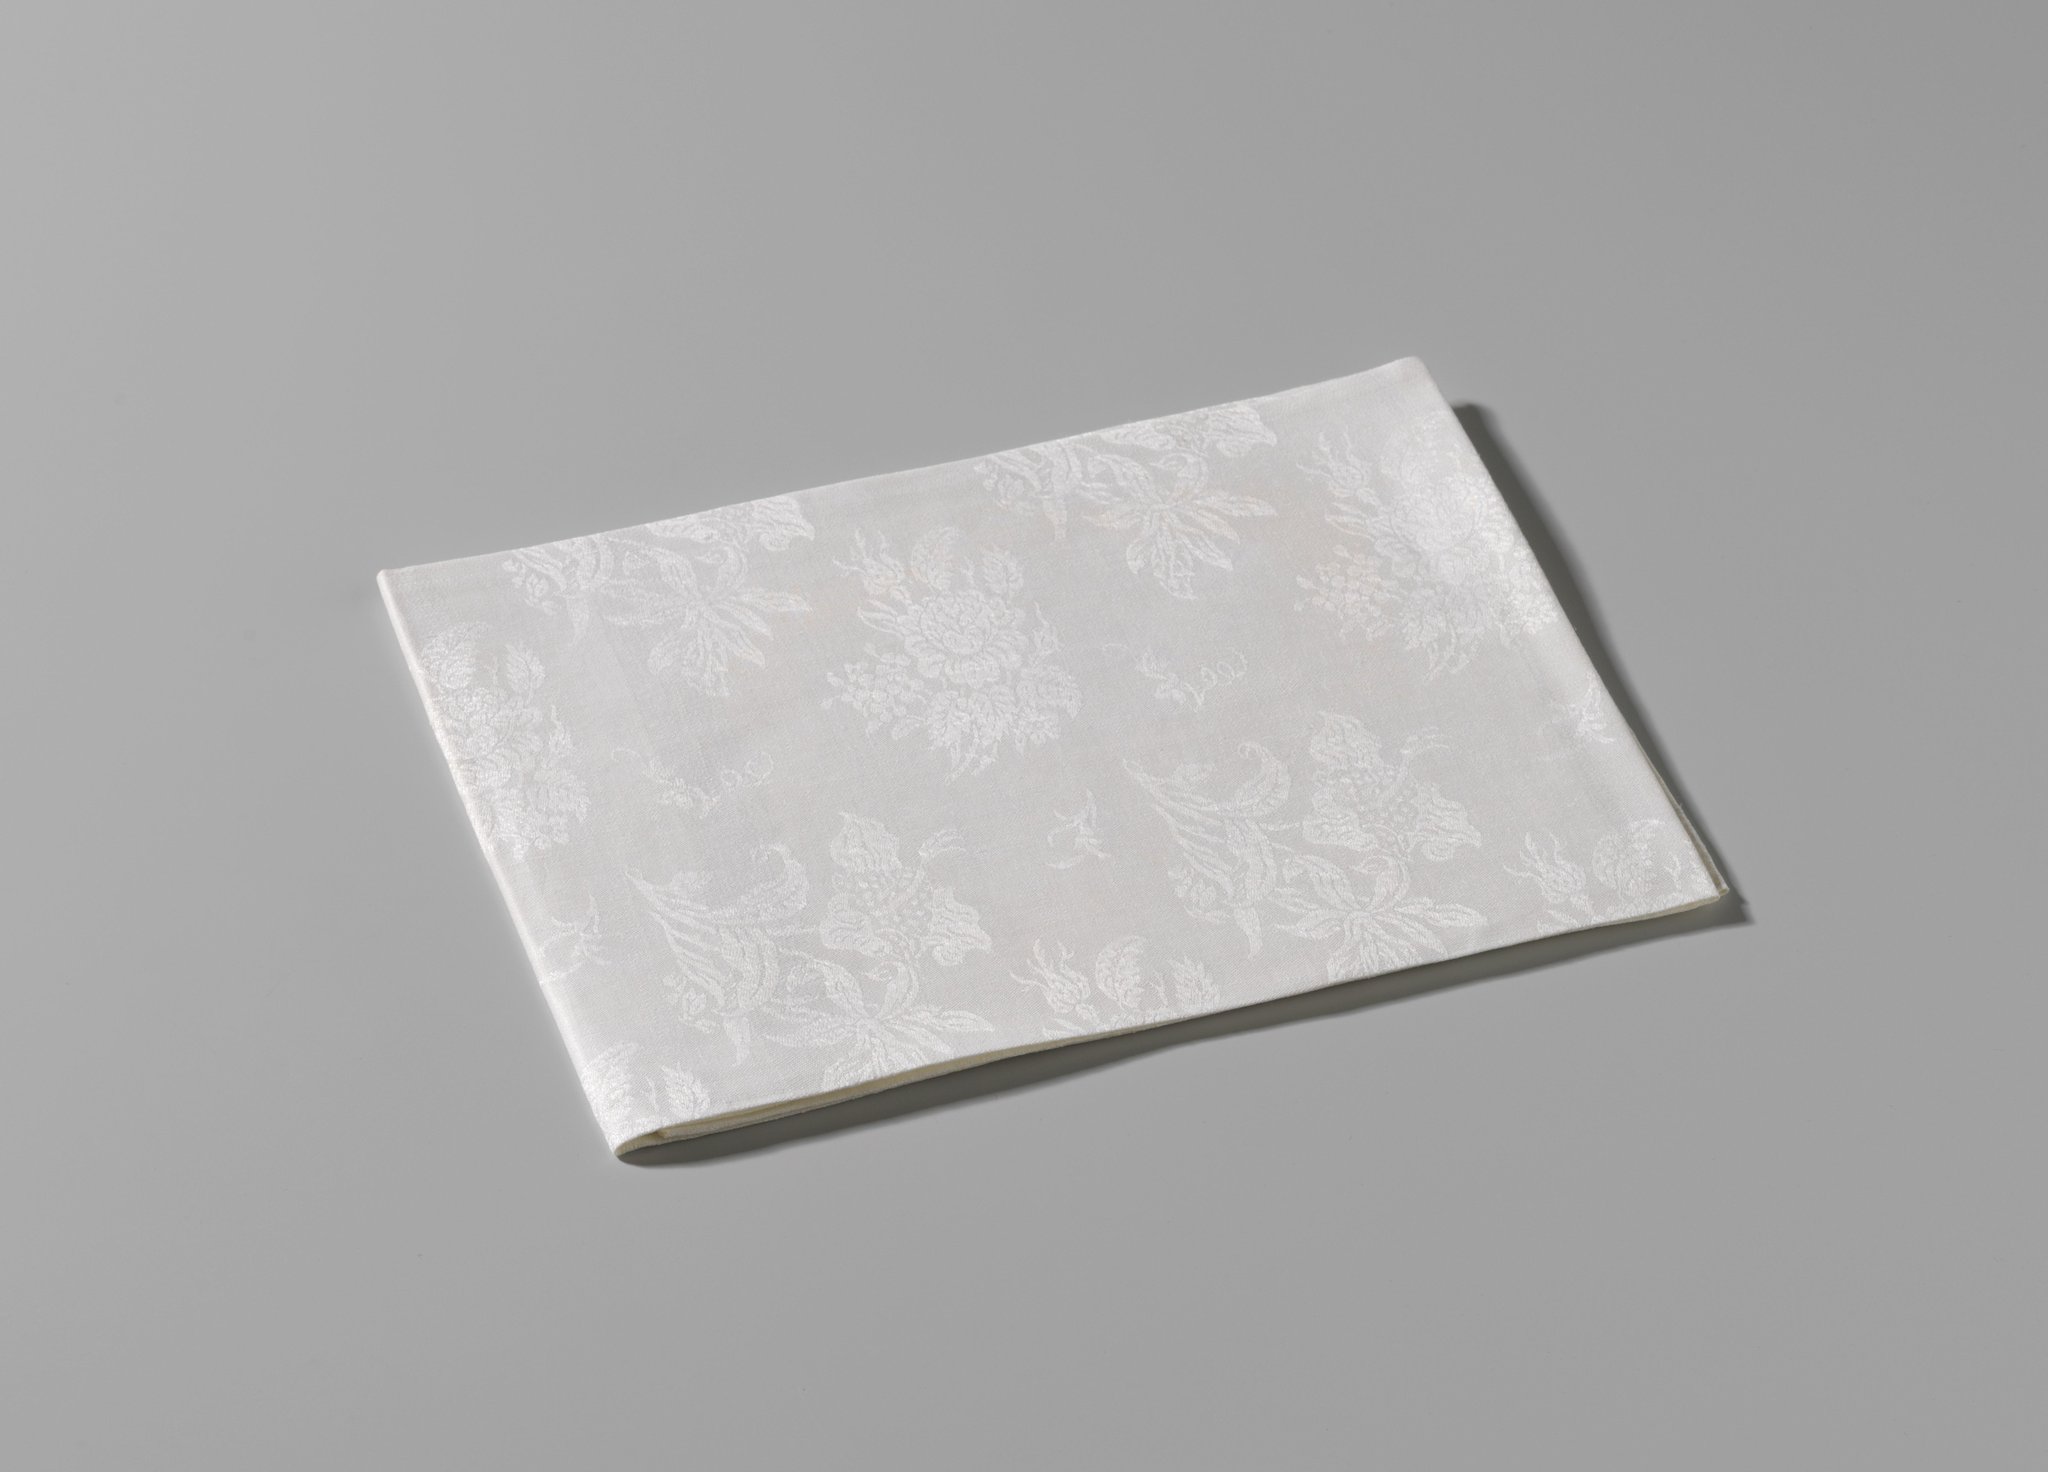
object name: napkin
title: Servet met bloemboeketten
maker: Anonymous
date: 1700-1899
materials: linen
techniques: damask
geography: saxony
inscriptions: mark: ‘GvO’, mark: ‘24’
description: Servet van linnendamast met bloemboeketten. Middenveld: Bloempatroon van verspringende rijen met twee soorten bloemboeketten. Staande en liggende randen: een bloemslinger, de hoeken een bloemboeket.